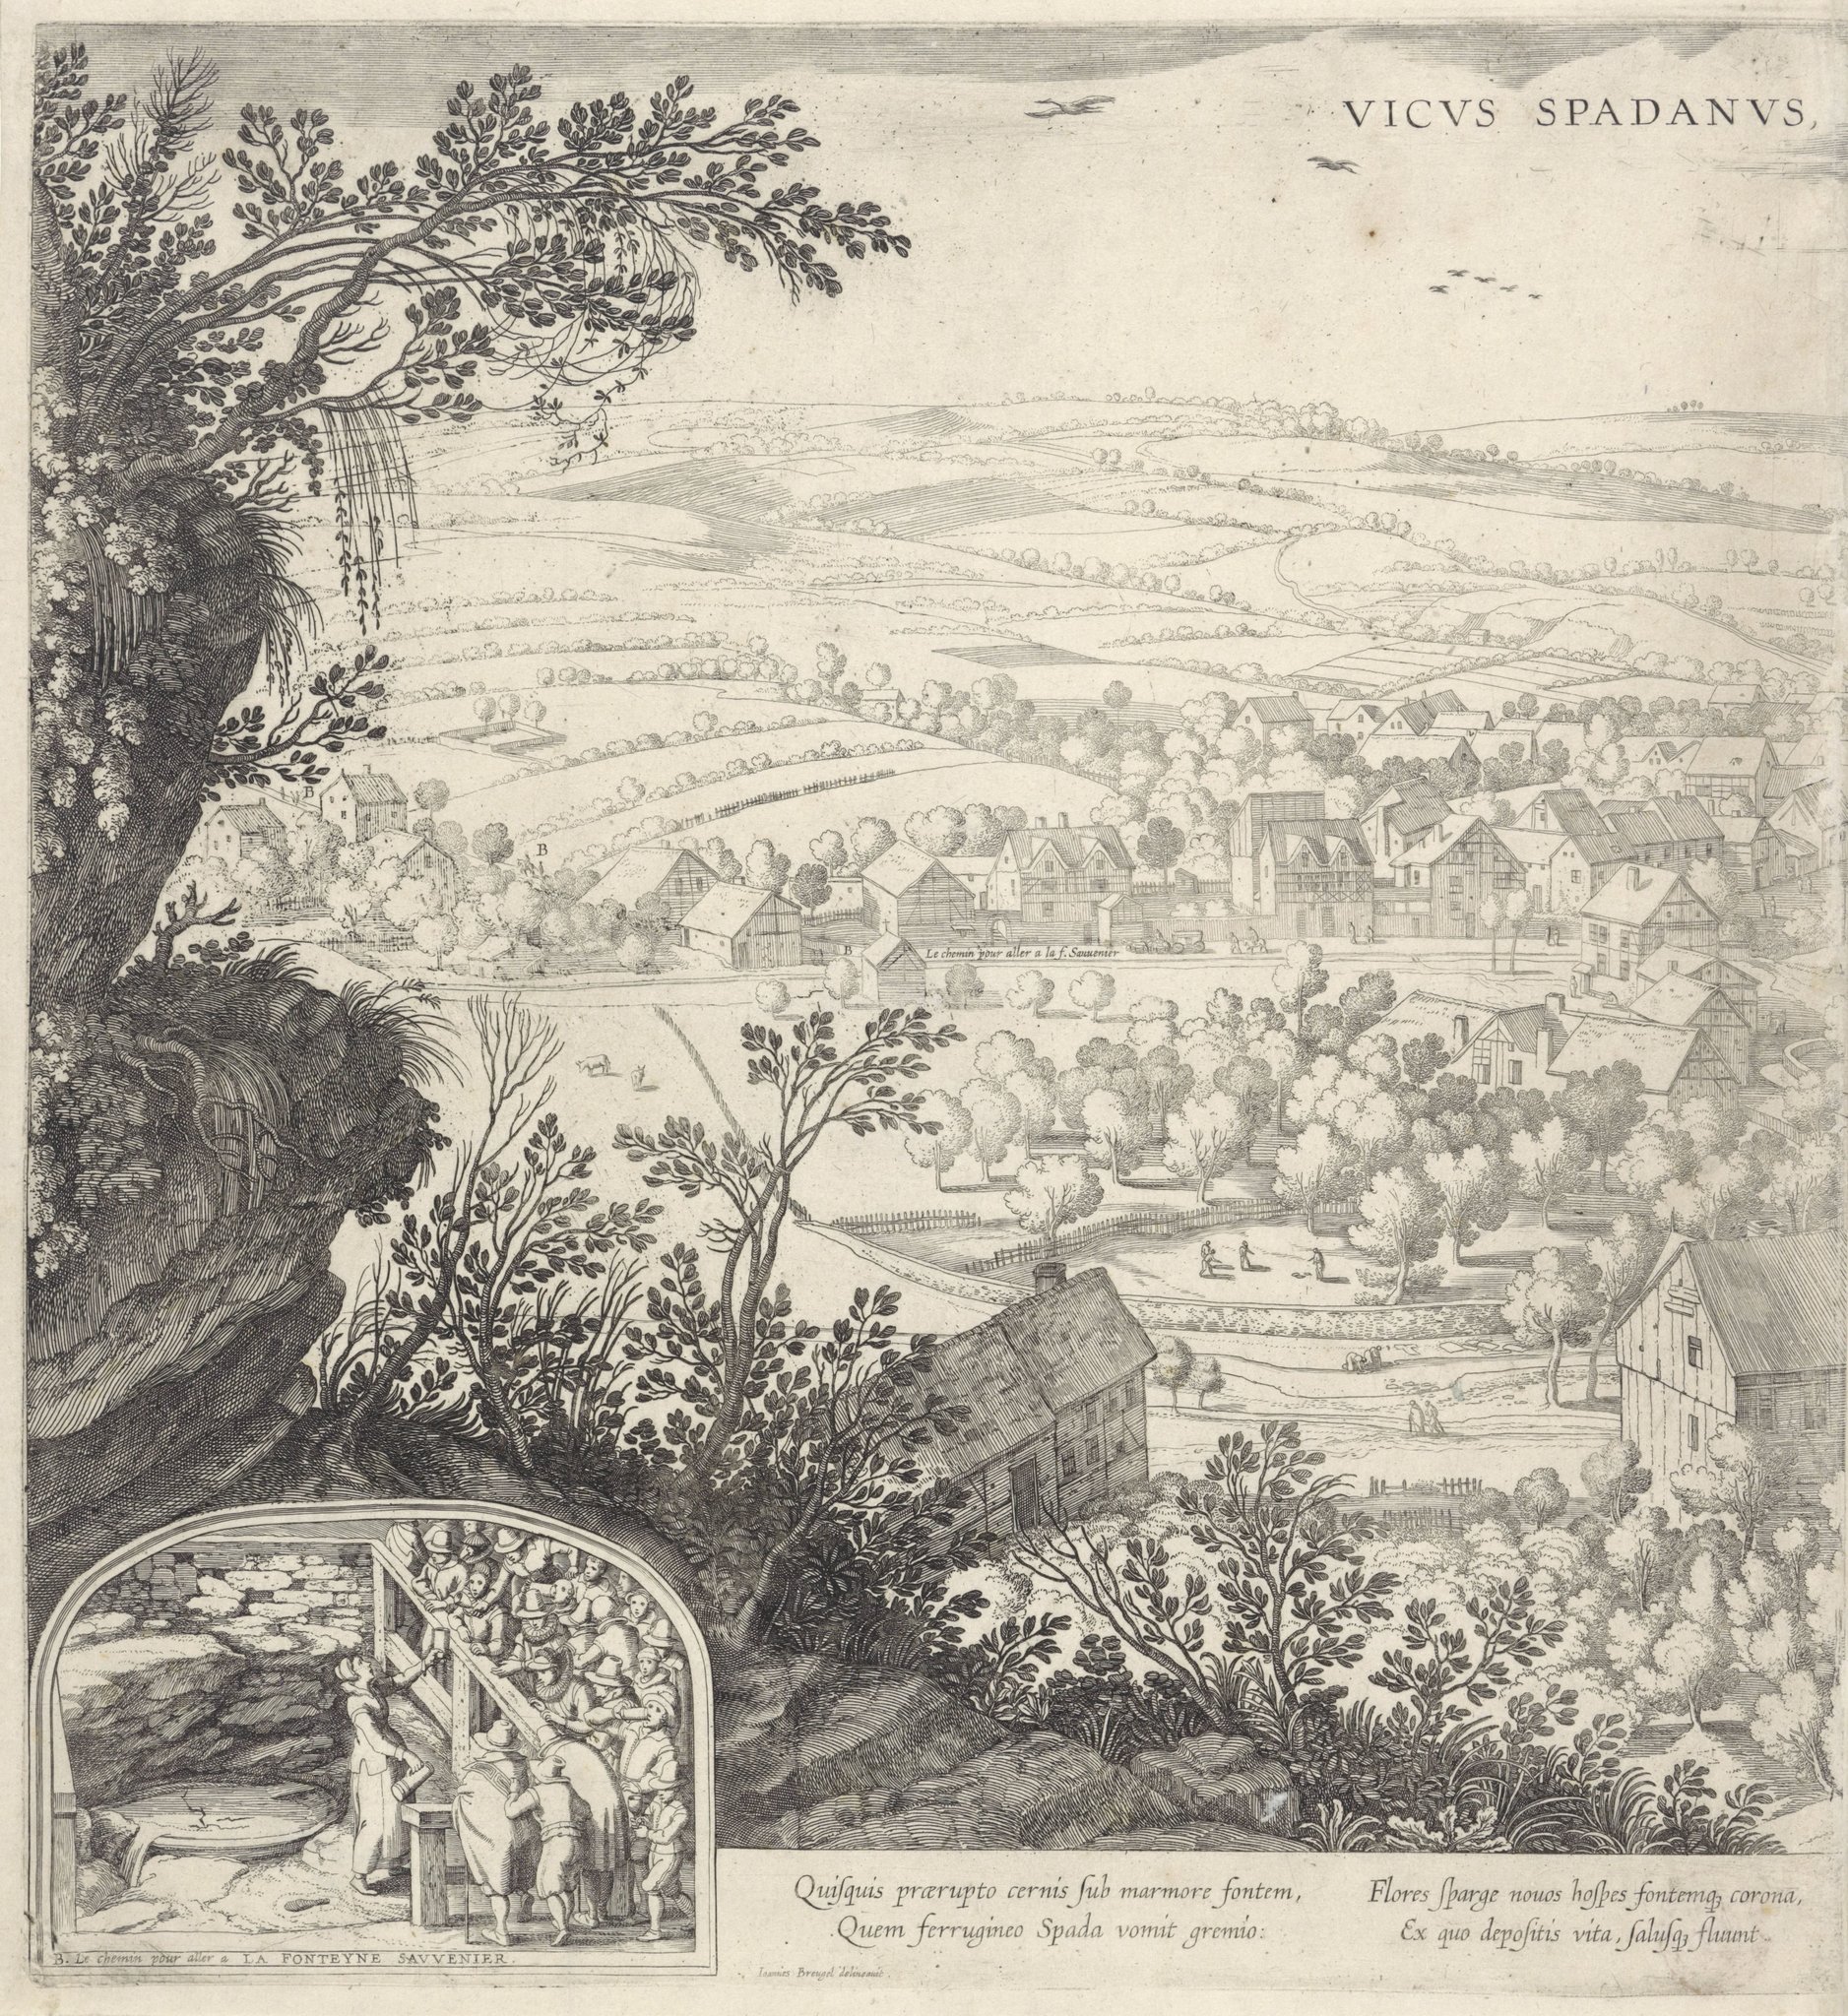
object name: print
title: Gezicht op Spa met de genezende bron (linker blad)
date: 1606-1628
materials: paper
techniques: etching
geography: antwerp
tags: mug, beaker, goblet, medicinal spring, village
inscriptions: collector's mark: Lugt 240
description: Linker blad van een gezicht op de stad Spa met de weg naar de geneeskrachtige bron (la fonteyne sauvenier) aangeduid met de letter B. Linksonder in de inzet deelt een vrouw bij de reddende bron bekers water uit aan de mensen, die achter een houten hek staan te wachten. Onderaan in de marge twee tweeregelige verzen in het Latijn.